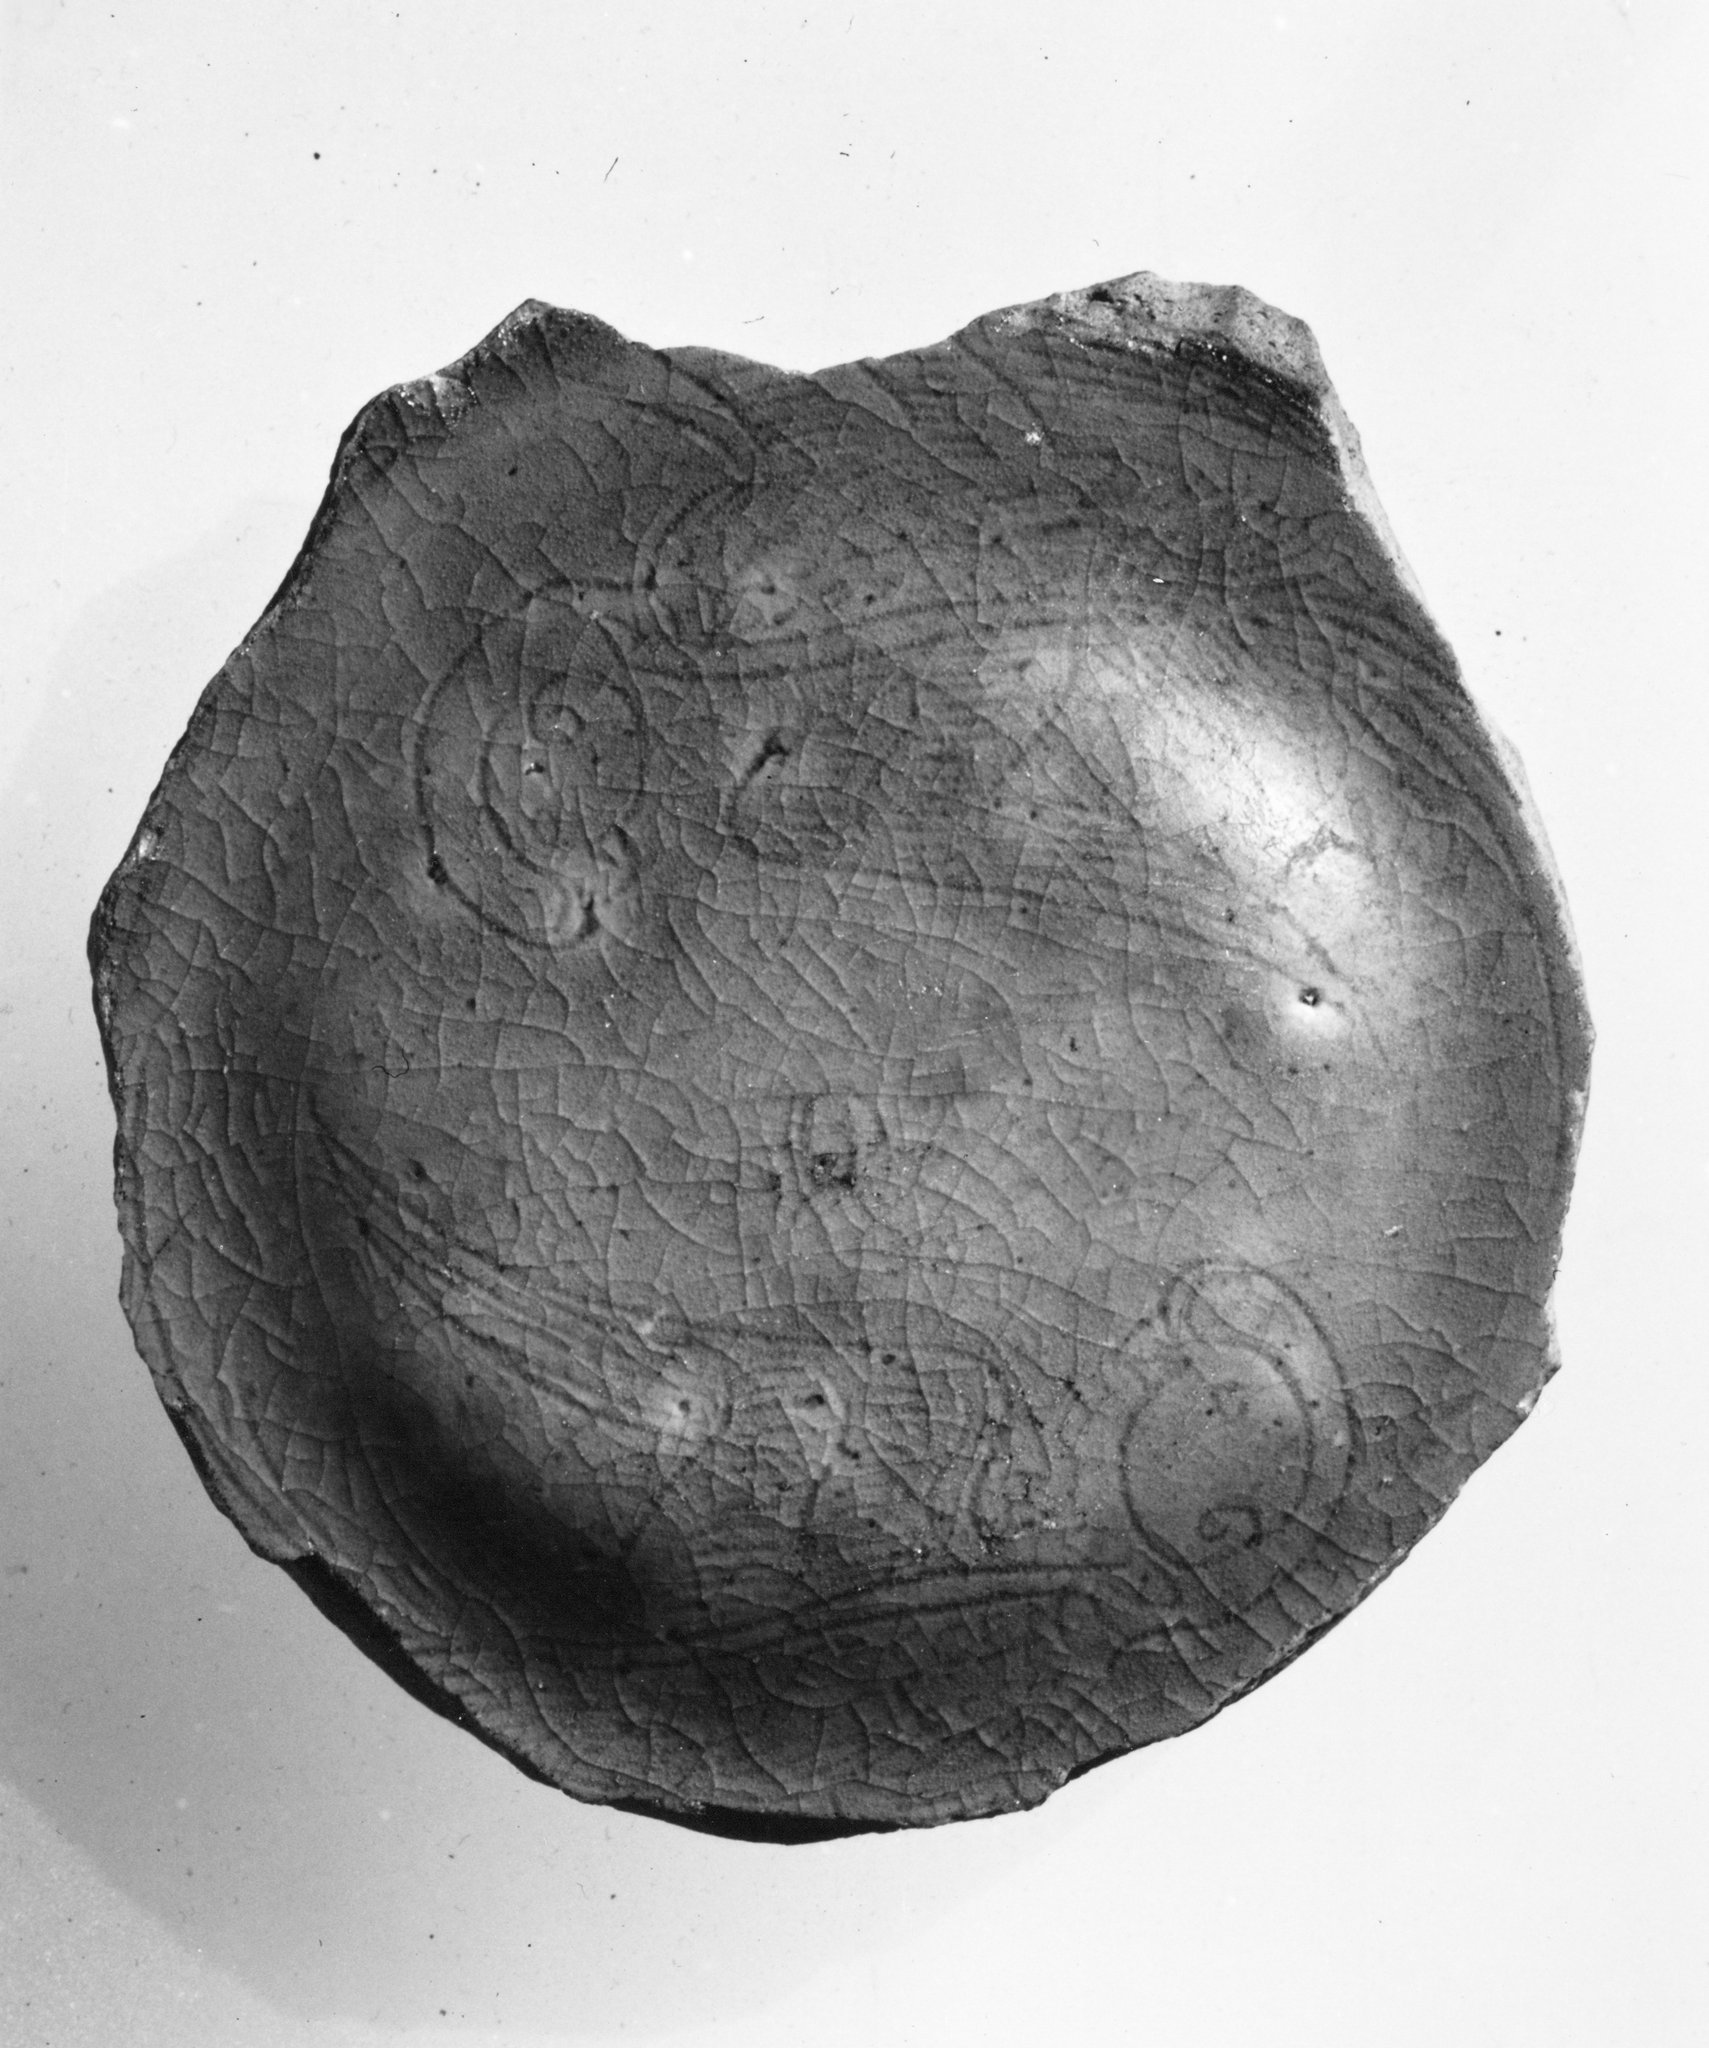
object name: sherd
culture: chinese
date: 960-983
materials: stoneware